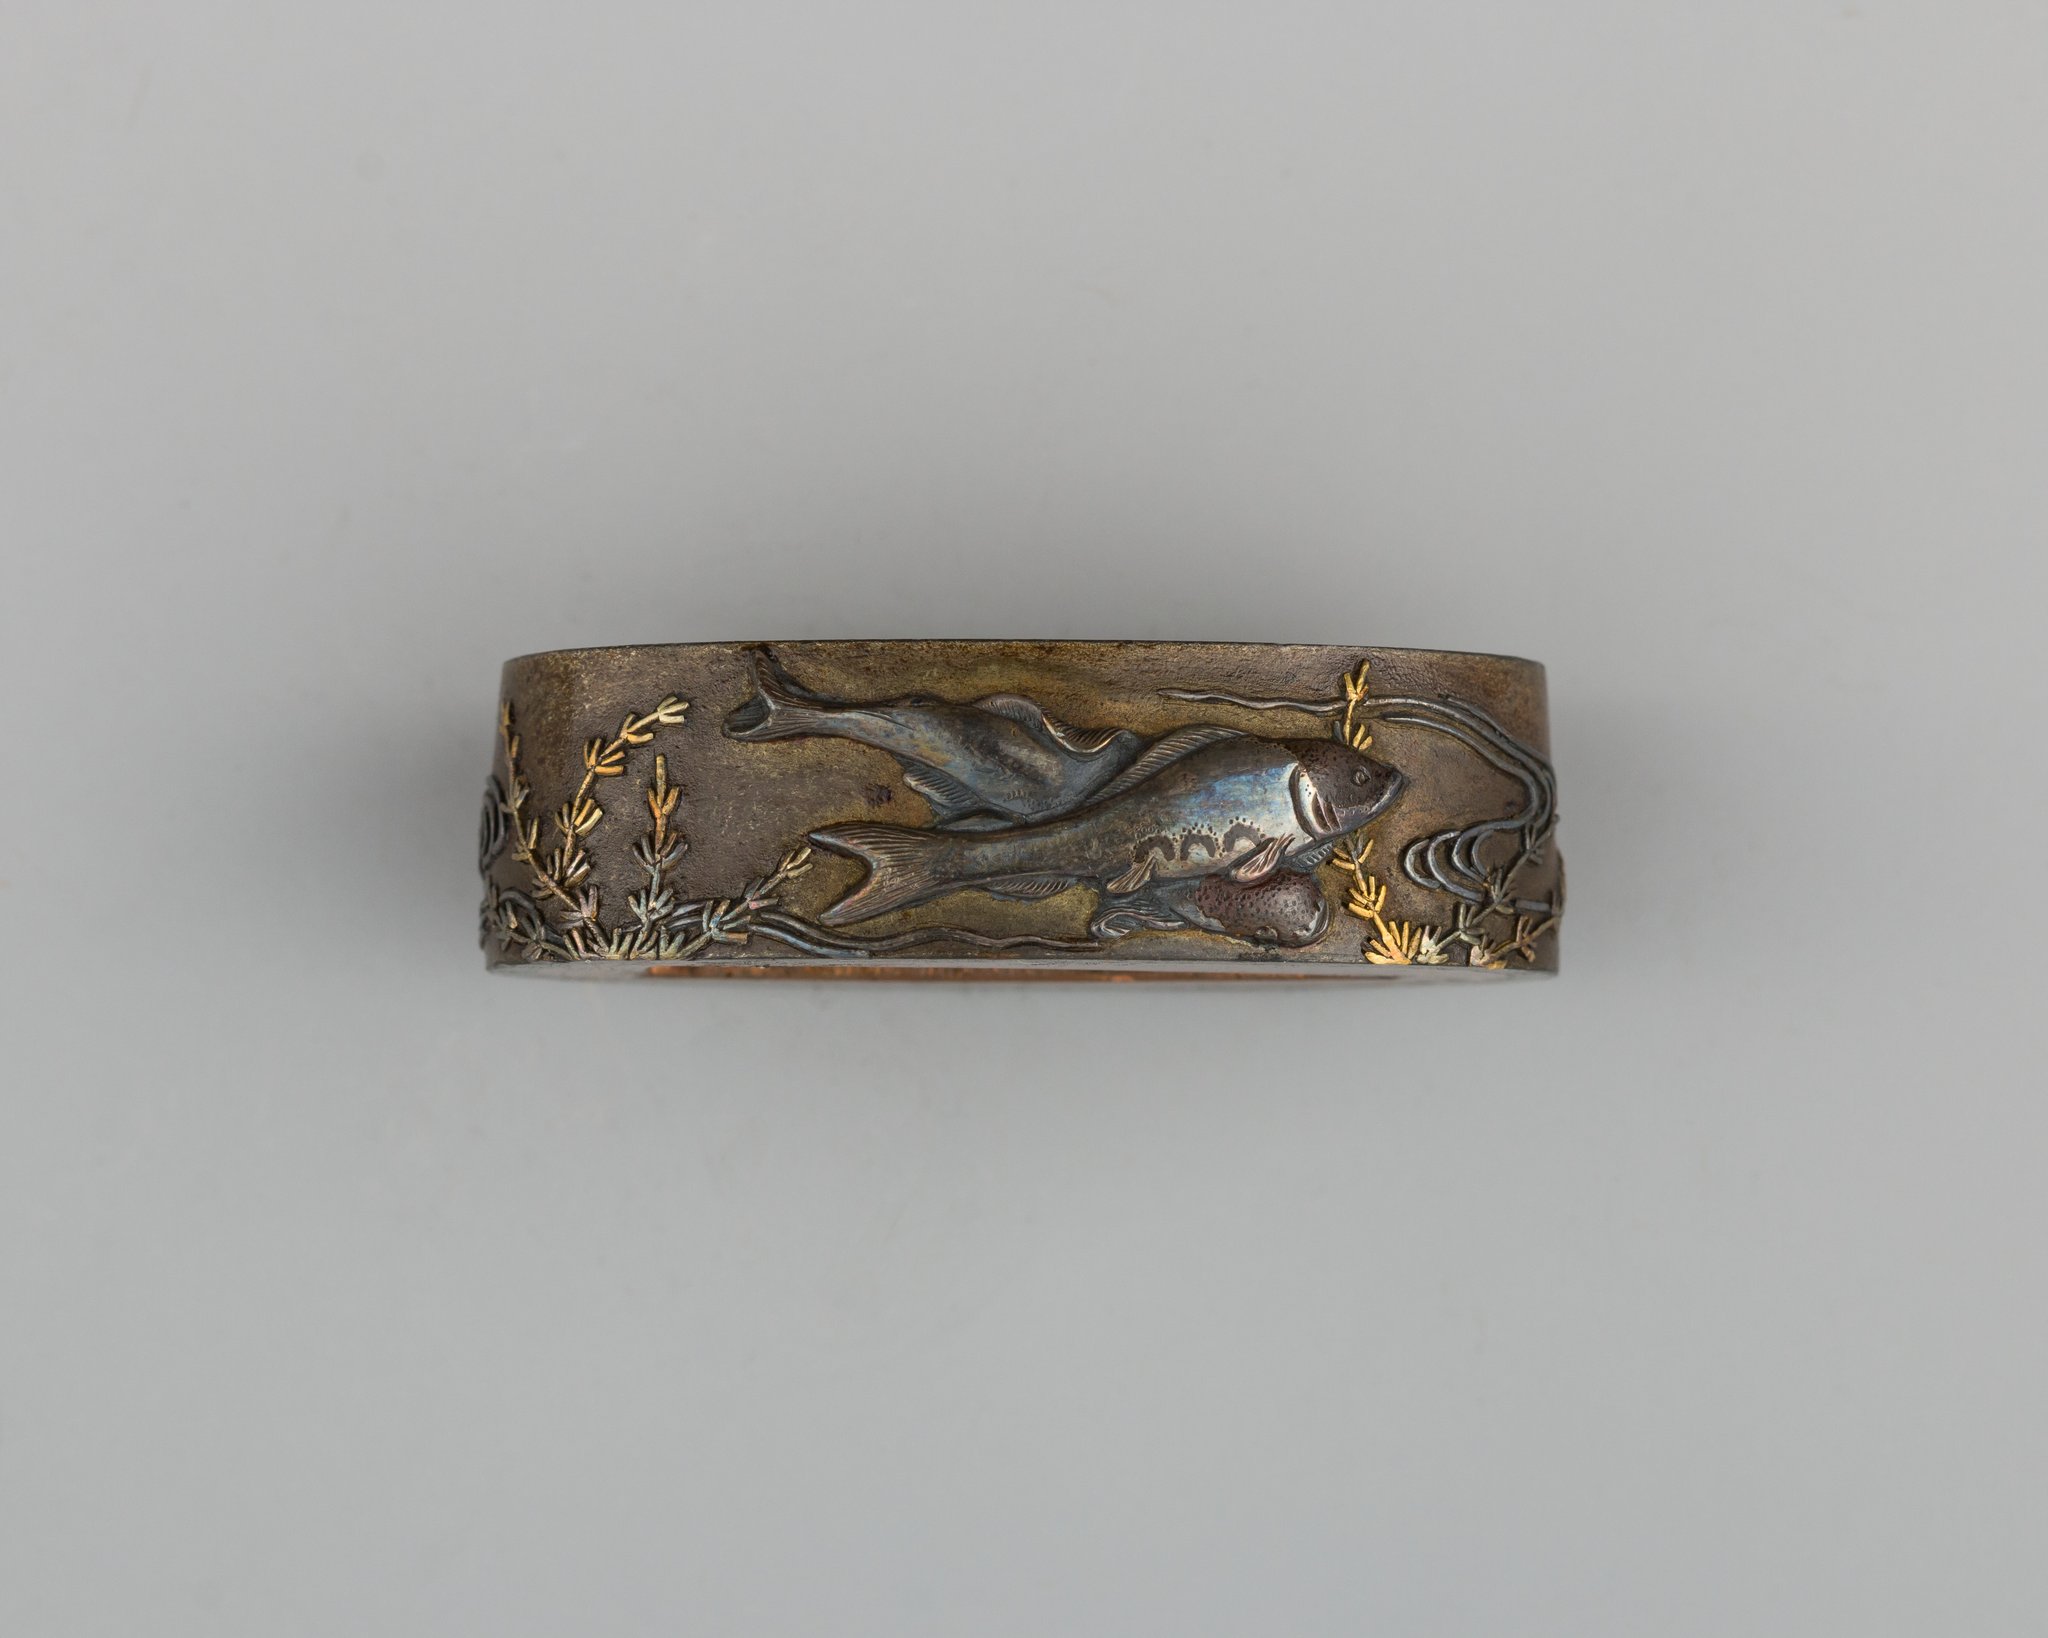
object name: sword hilt collar fuchi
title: Sword-Hilt Collar (Fuchi)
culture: japanese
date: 1615-1868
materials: copper, silver alloy, gold, silver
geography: japan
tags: fish